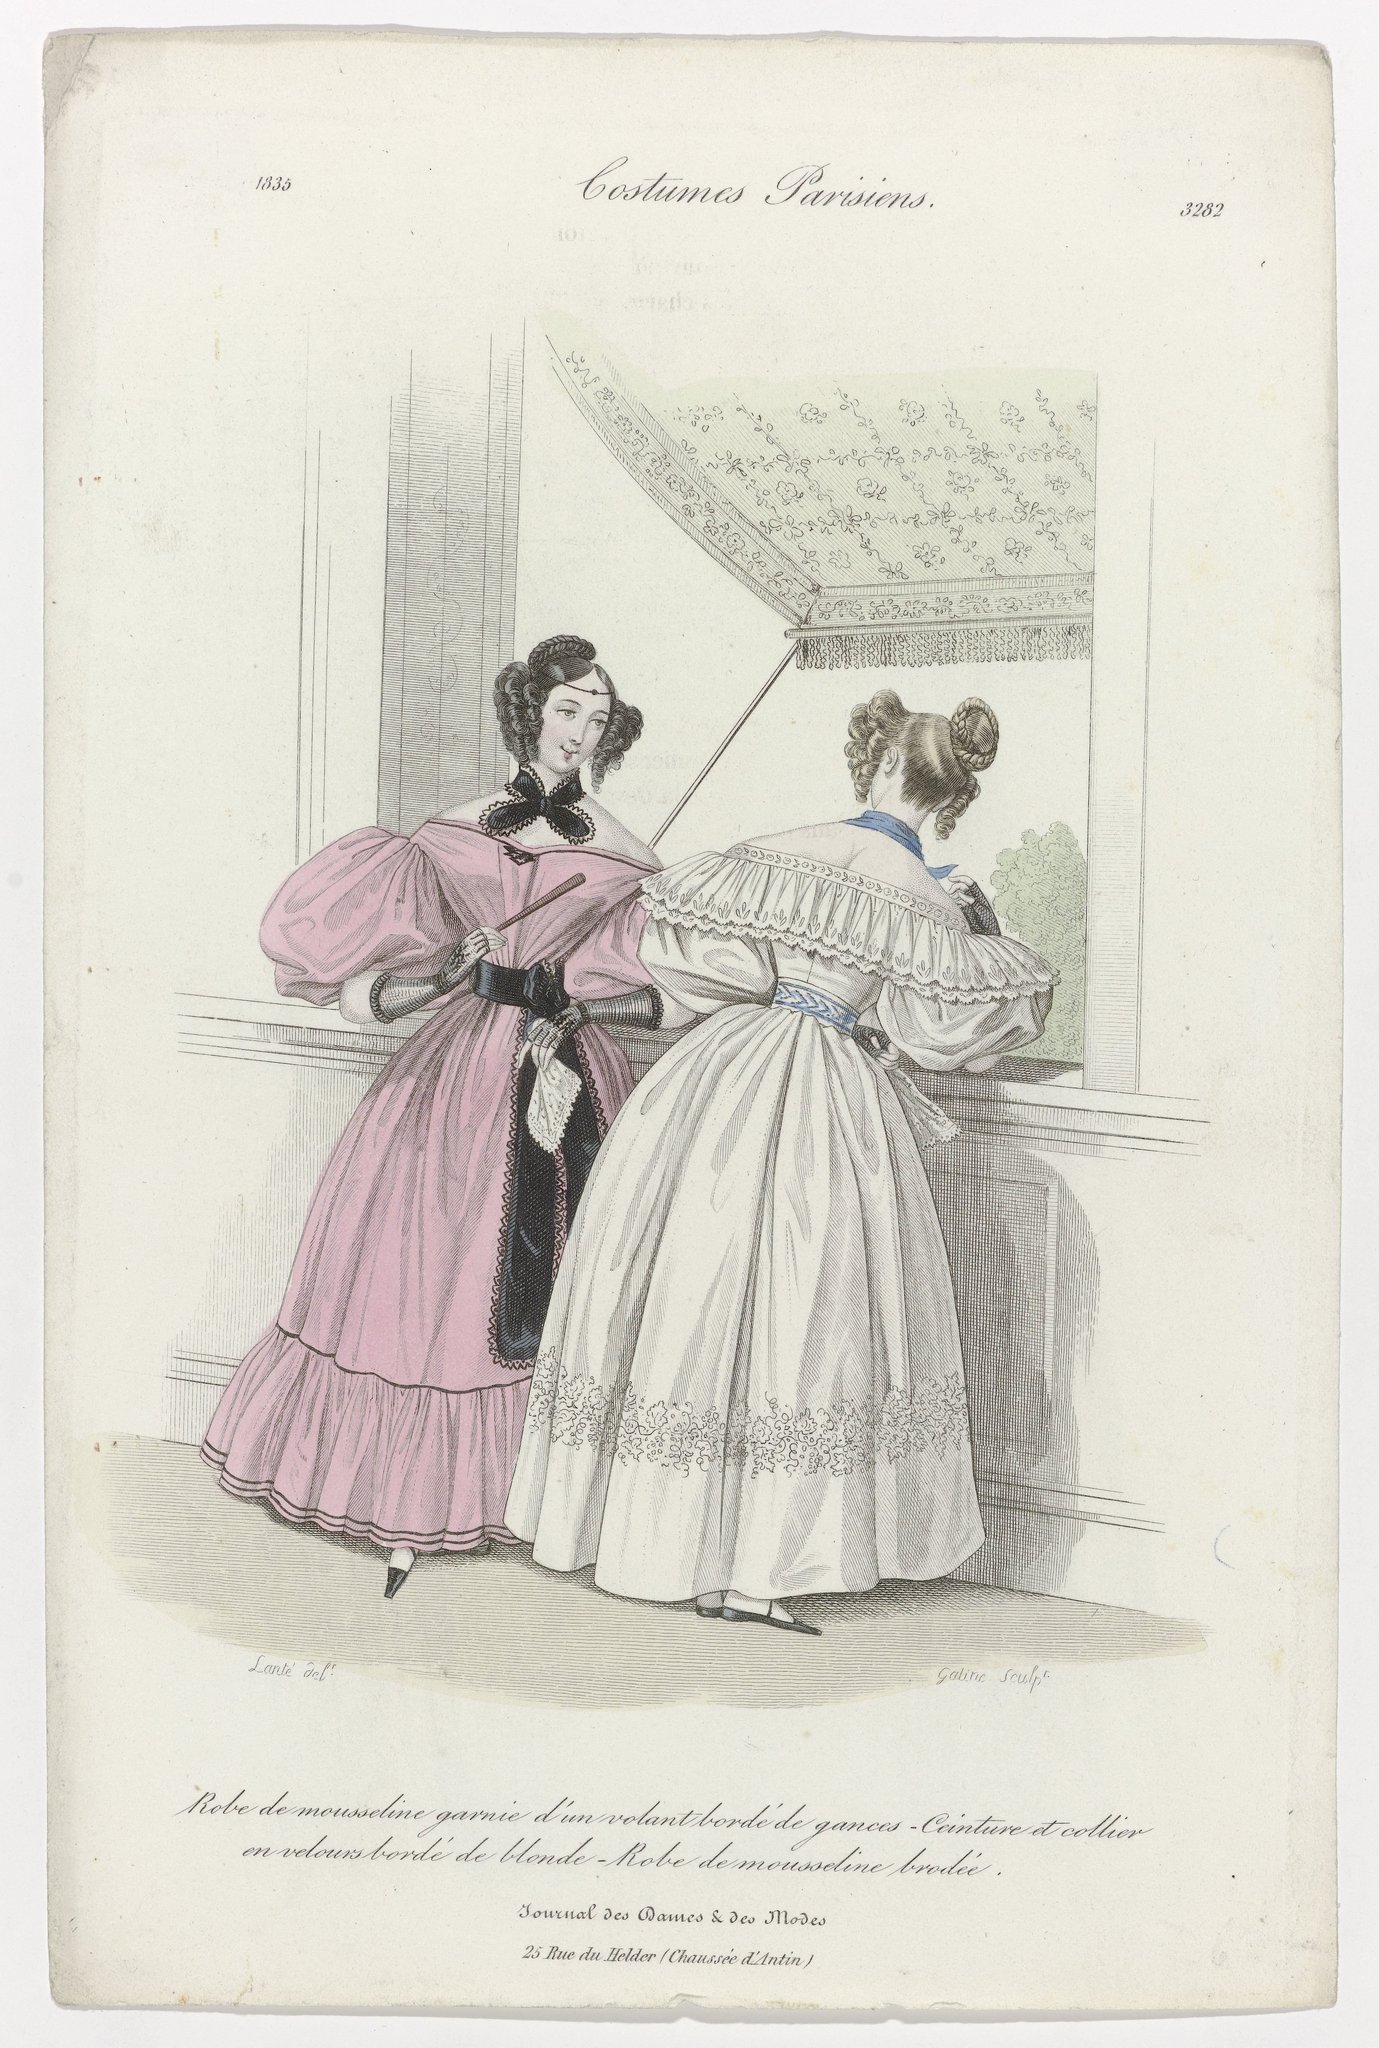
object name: fashion print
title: Journal des Dames et des Modes, Costumes Parisiens 1835 (3282): Robe de mousselin (...)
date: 1835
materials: paper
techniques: engraving, hand coloring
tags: handkerchief (+ women's clothes), ornamental parts of clothing (+ women's clothes), embroidery (ornamentation) (+ women's clothes), gloves, mittens (mitaines) (+ women's clothes), fashion plates, shoes, sandals (+ women's clothes), dress, gown (+ women's clothes), fan (+ women's clothes), human figure at (open) window, seen from inside, necklace (+ women's clothes), belt, girdle, waistband (+ women's clothes)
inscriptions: address: ‘Journal des Dames & des Modes / 25 Rue du Helder (Chaussée d'Antin)’, caption: ‘Robe de mousseline garnie d'un volant bordé de gances - Ceinture et collier en velours bordé de blonde - Robe de mousseline brodée.’, title: ‘Costumes Parisiens.’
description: Twee vrouwen in een interieur, staande bij een open raam. Links: japon van mousseline, afgezet met gerimpelde strook stof met 'gances'. Ceintuur en collier van fluweel, afgezet met Blonde (kloskant). Verdere accessoires: mitaines, waaier, zakdoek, platte schoen met vierkante neus. Rechts: japon van geborduurde mousseline. Accessoires: mitaines, zakdoek, ceintuur(?), platte schoenen met banden. De prent maakt deel uit van het modetijdschrift Journal des Dames et des Modes, Parijs, 1797-1839.